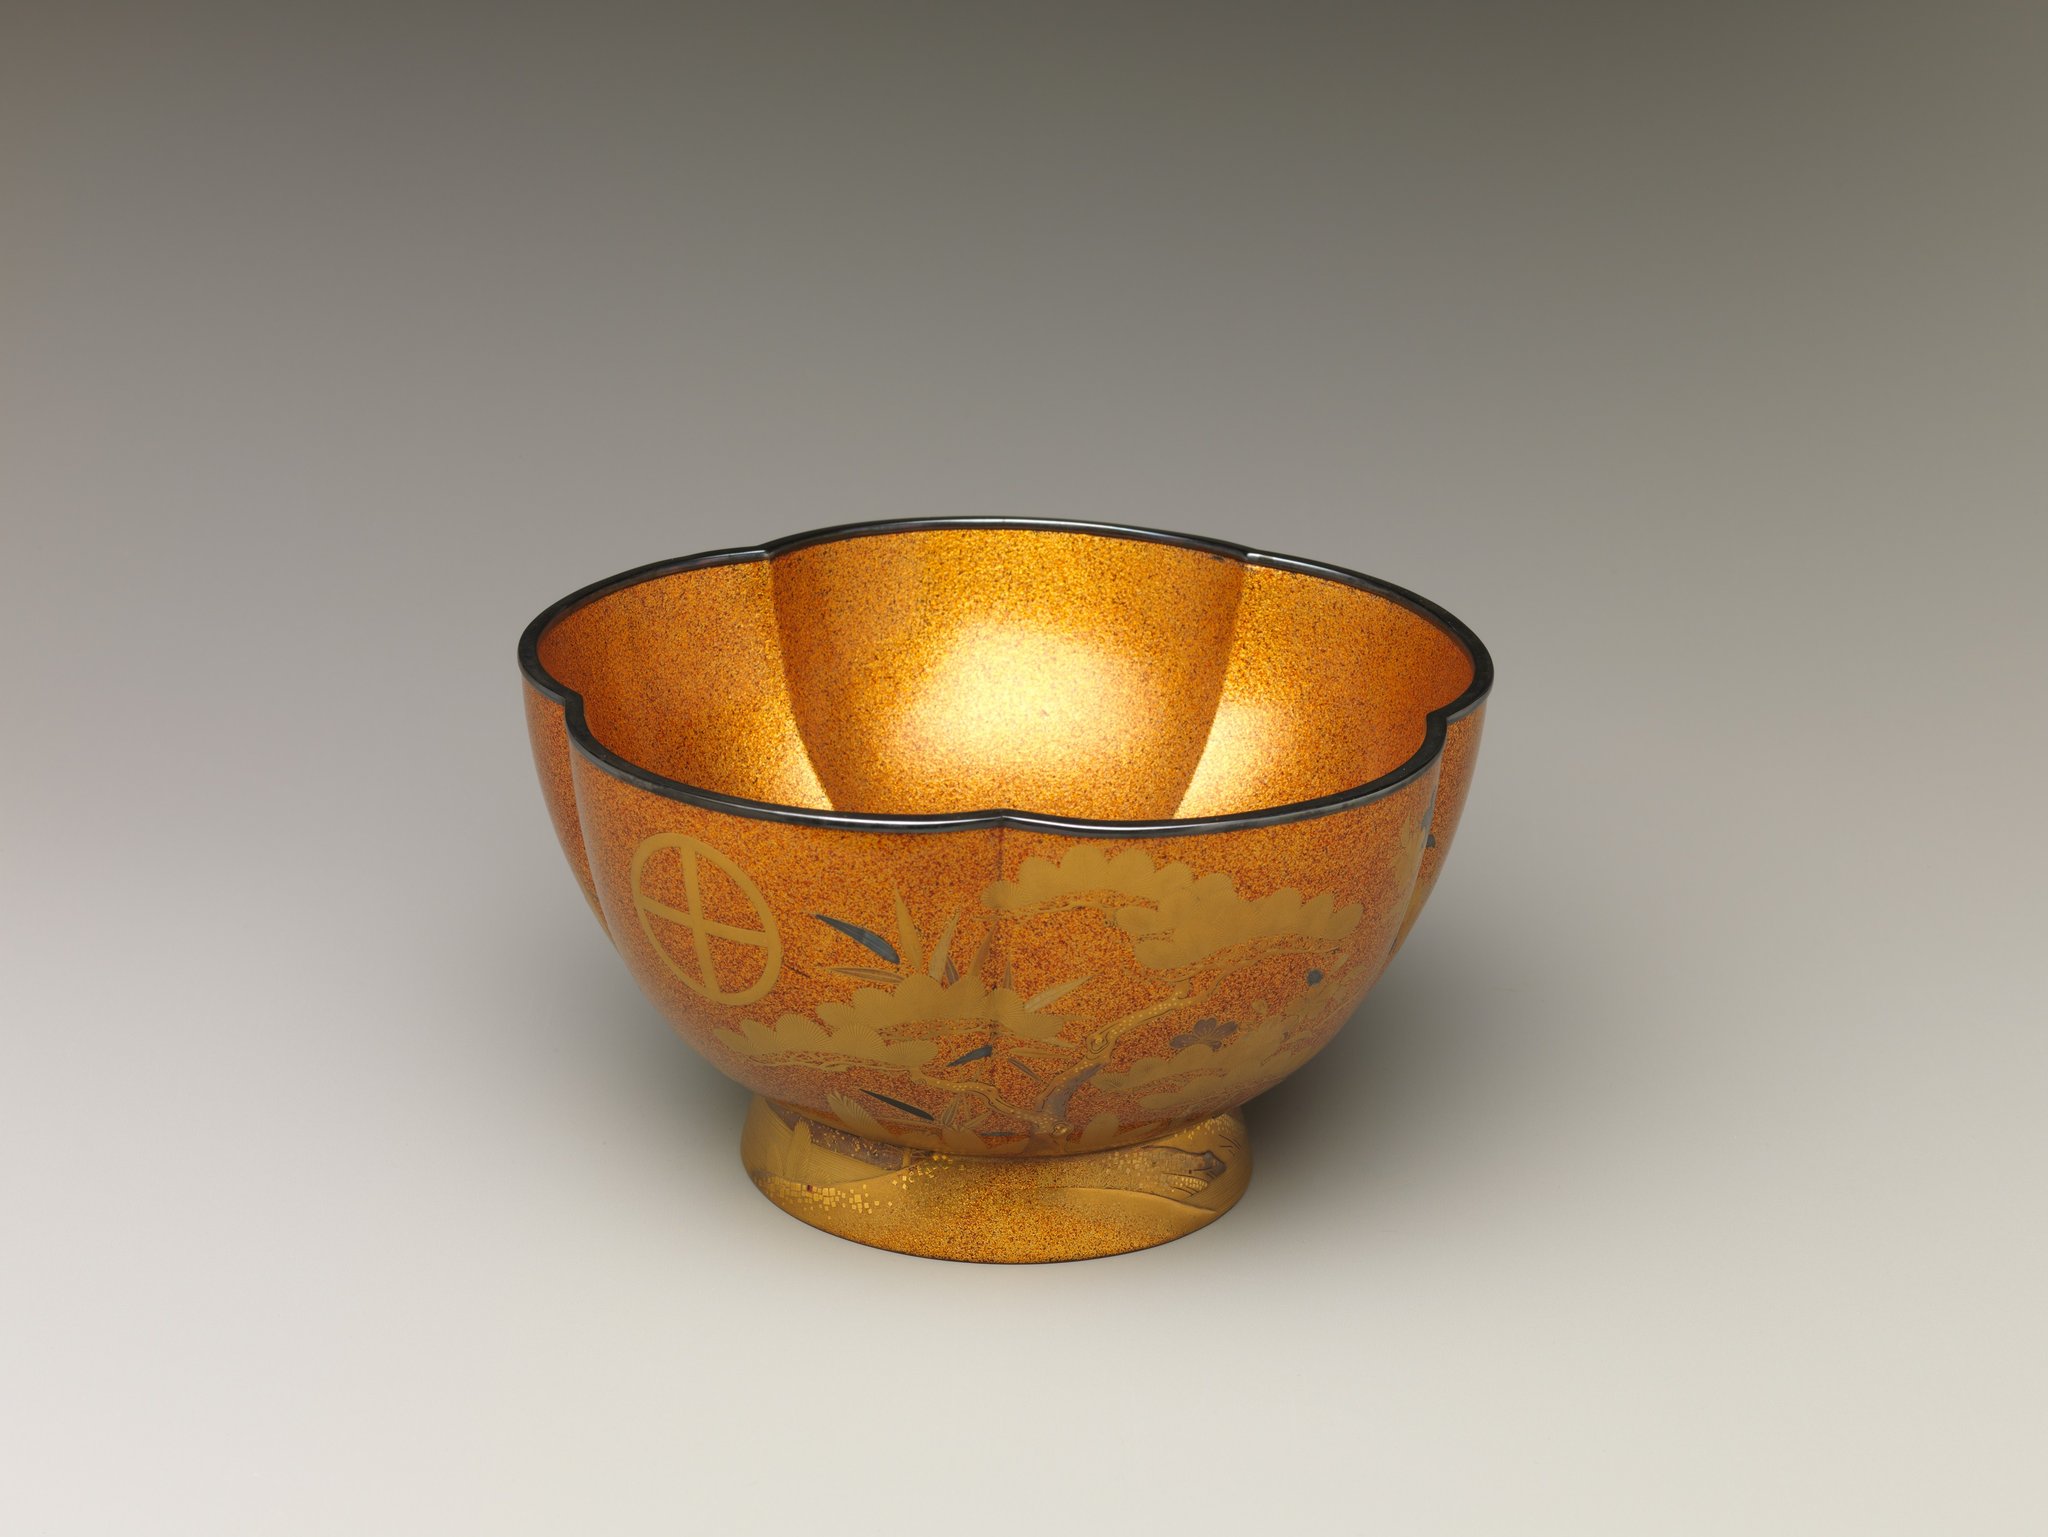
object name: bowl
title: Bowl with with Design of Pine, Bamboo, and Cherry Blossom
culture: japanese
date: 1801-1900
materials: gold, lacquer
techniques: maki